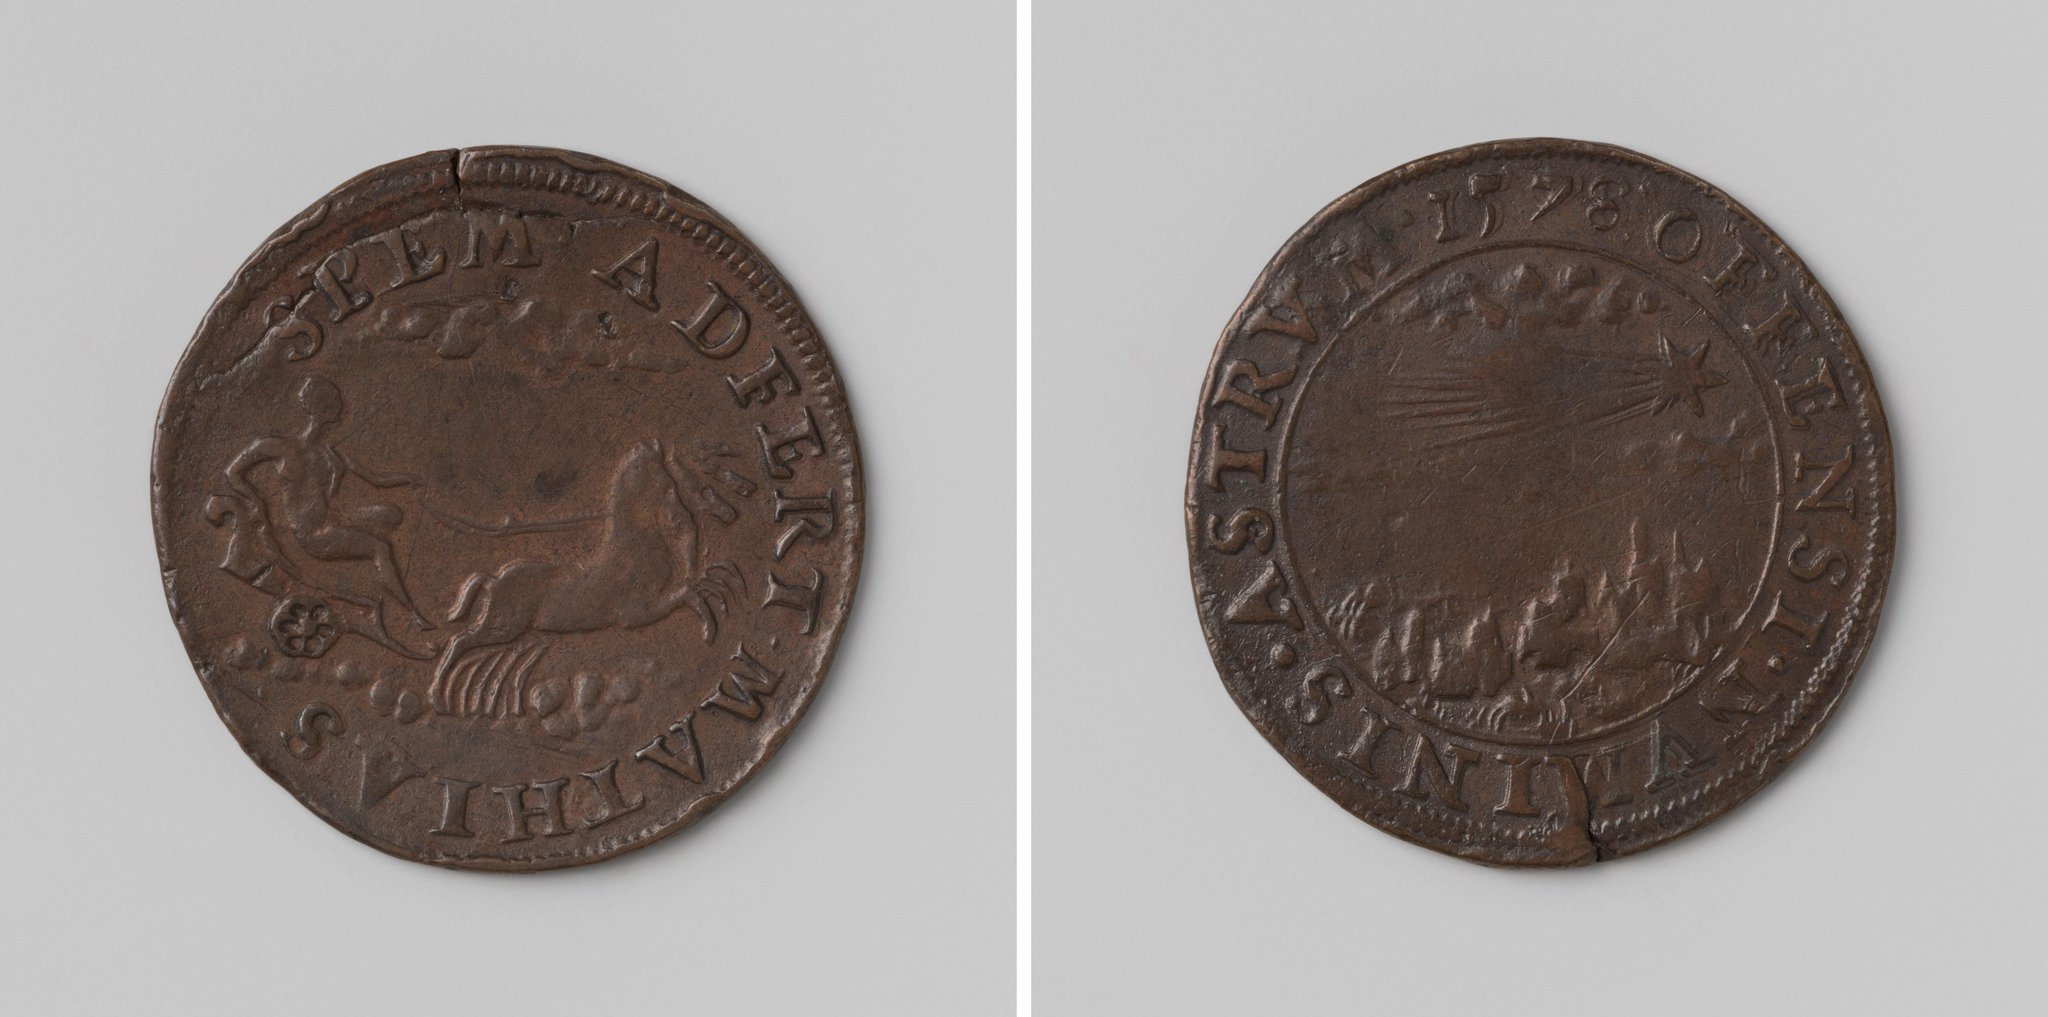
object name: jeton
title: Aankomst van Matthias, aartshertog van Oostenrijk in de Nederlanden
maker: Anonymous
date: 1578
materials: copper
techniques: striking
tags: matthias van oostenrijk (rooms-duits keizer)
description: Koperen penning. Voorzijde: jongeman, staande op vierspan, beschenen door zon binnen omschrift. Keerzijde: komeet boven landschap binnen omschrift